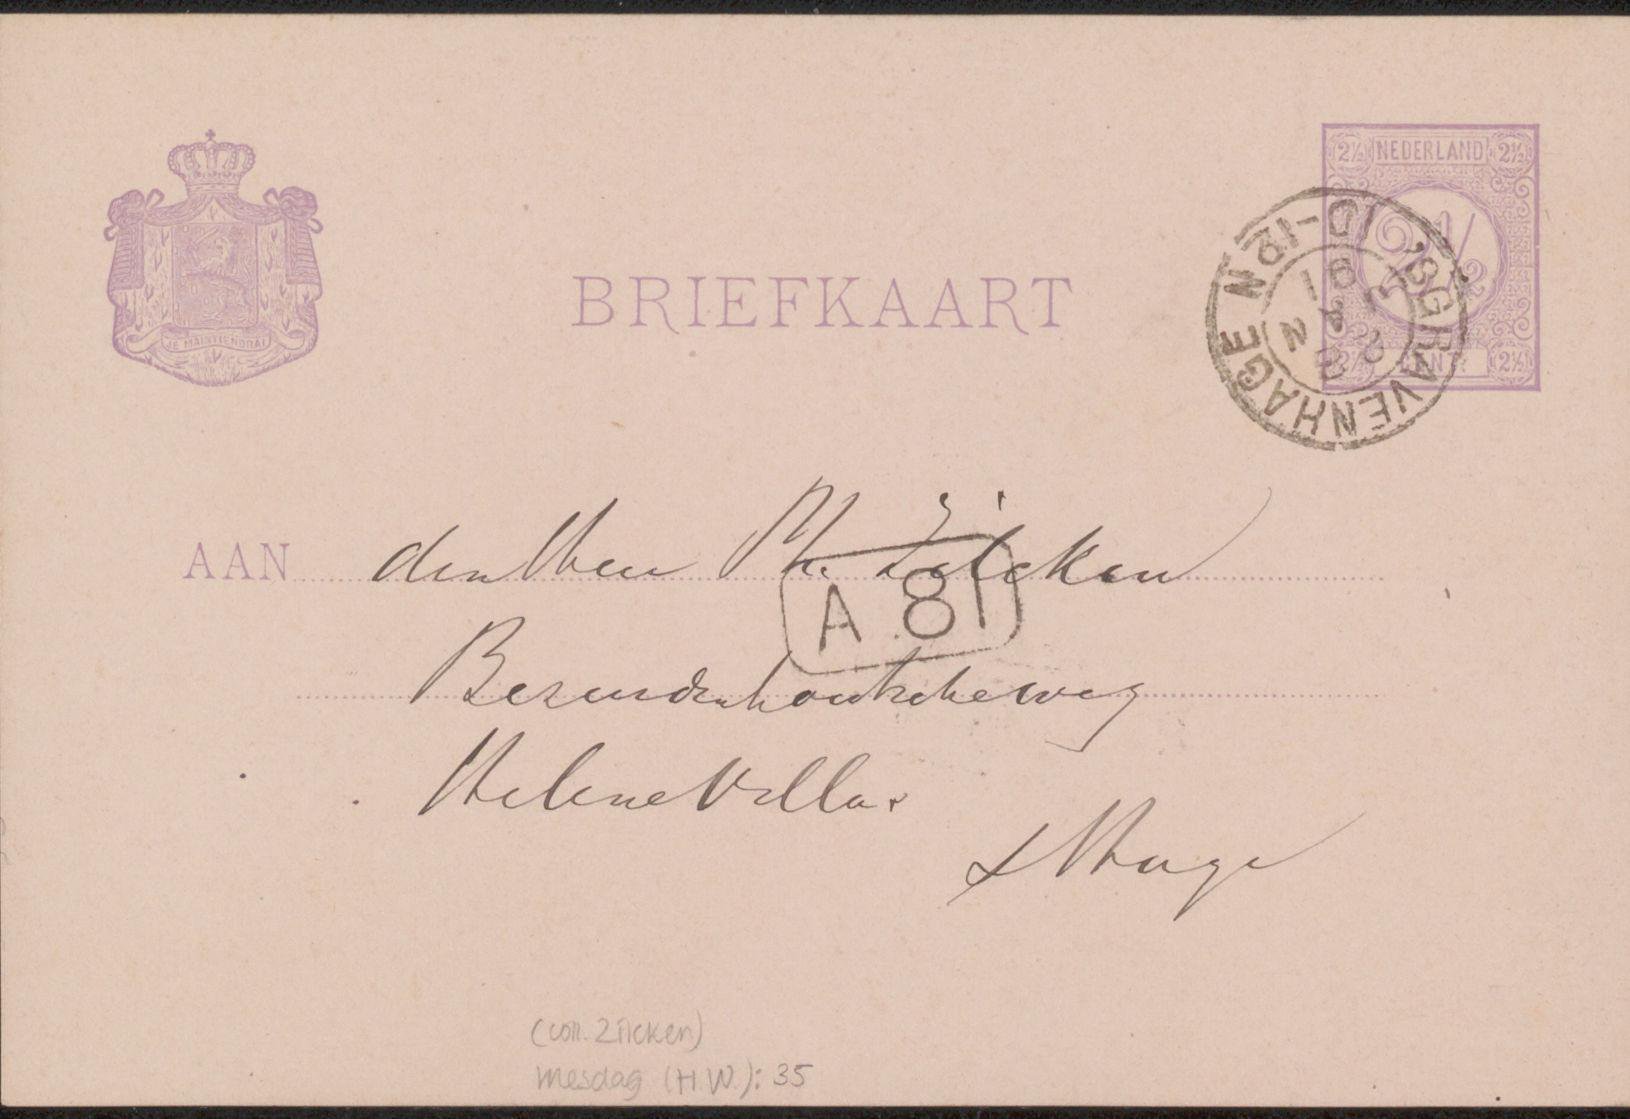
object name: postcard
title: Briefkaart aan Philip Zilcken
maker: hendrik willem mesdag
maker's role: draughtsman, painter, print maker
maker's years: 1831-1915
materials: cardboard, ink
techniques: pen, writing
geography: the hague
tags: philip zilcken